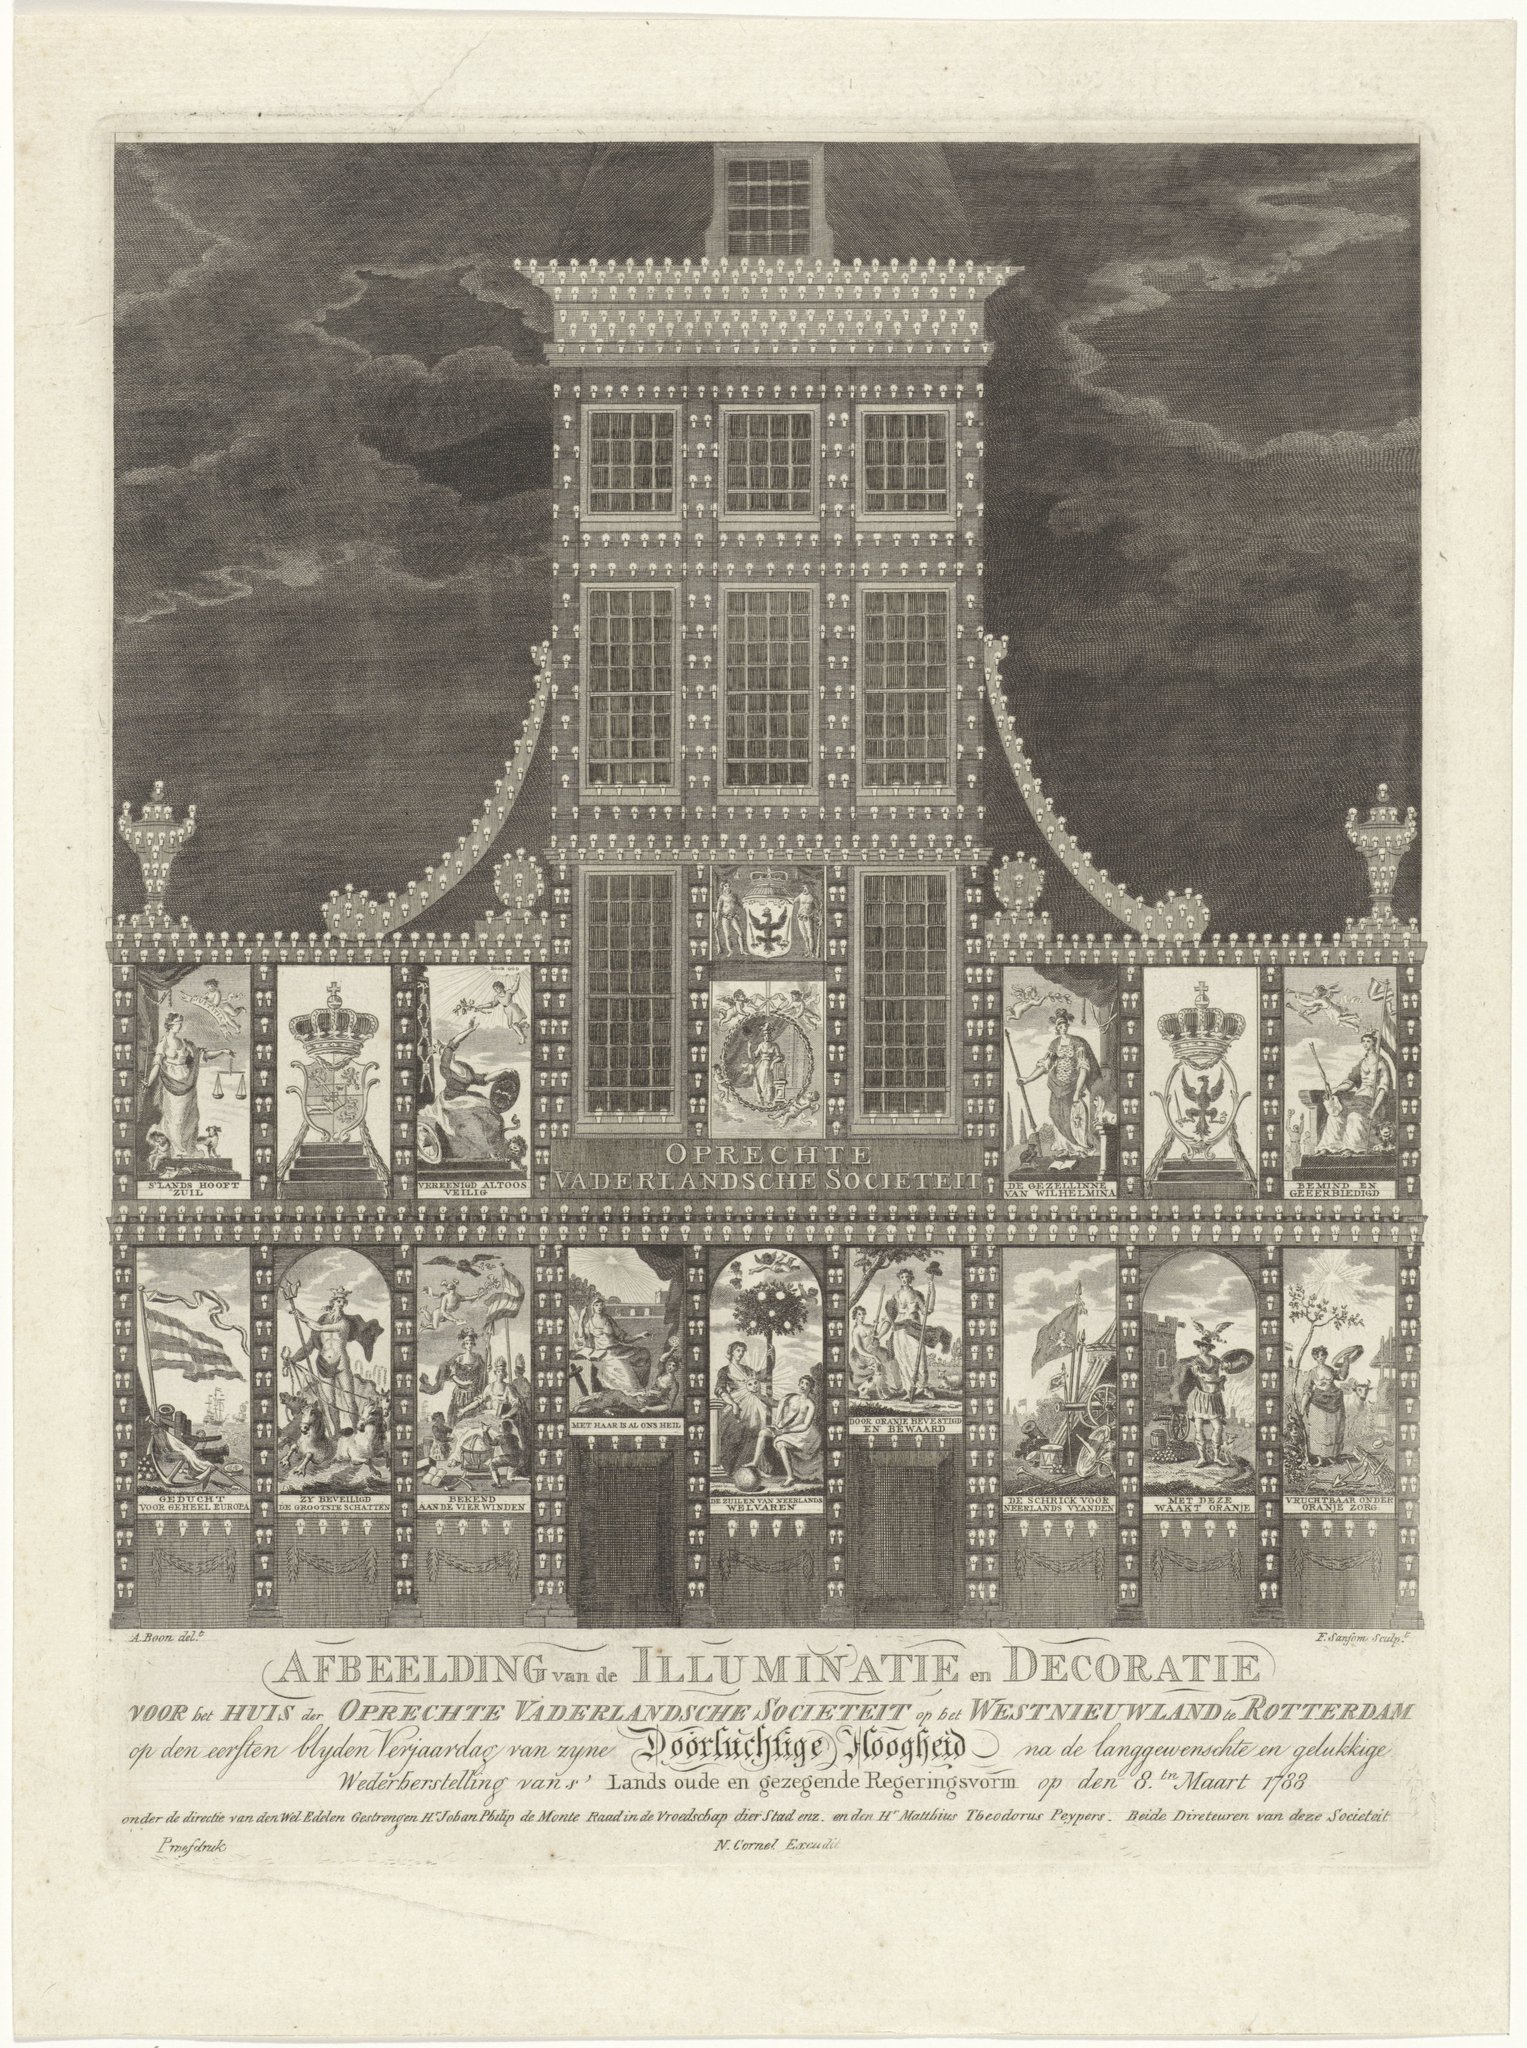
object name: print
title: Illuminatie van het pand van de Oprechte Vaderlandsche Sociëteit op het Westnieuwland te Rotterdam, 1788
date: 1788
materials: paper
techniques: engraving, etching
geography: rotterdam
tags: the hague, william v (prince of orange), public festivities at other royal events, not meant or mentioned above (+ illumination, fire-works ~ festive activities), bonfire, fire-works (+ illumination, fire-works ~ festive activities), rotterdam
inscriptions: collector's mark: Lugt 2760, collector's mark: Lugt 2166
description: Illuminatie van de gevel van het pand van de Oprechte Vaderlandsche Sociëteit op het Westnieuwland te Rotterdam, ter gelegenheid van de veertigste verjaardag van prins Willem V op 8 maart 1788 en het herstel van de oude constitutie. De gevel versierd met lichtjes en chassinetten met allegorische voorstellingen.